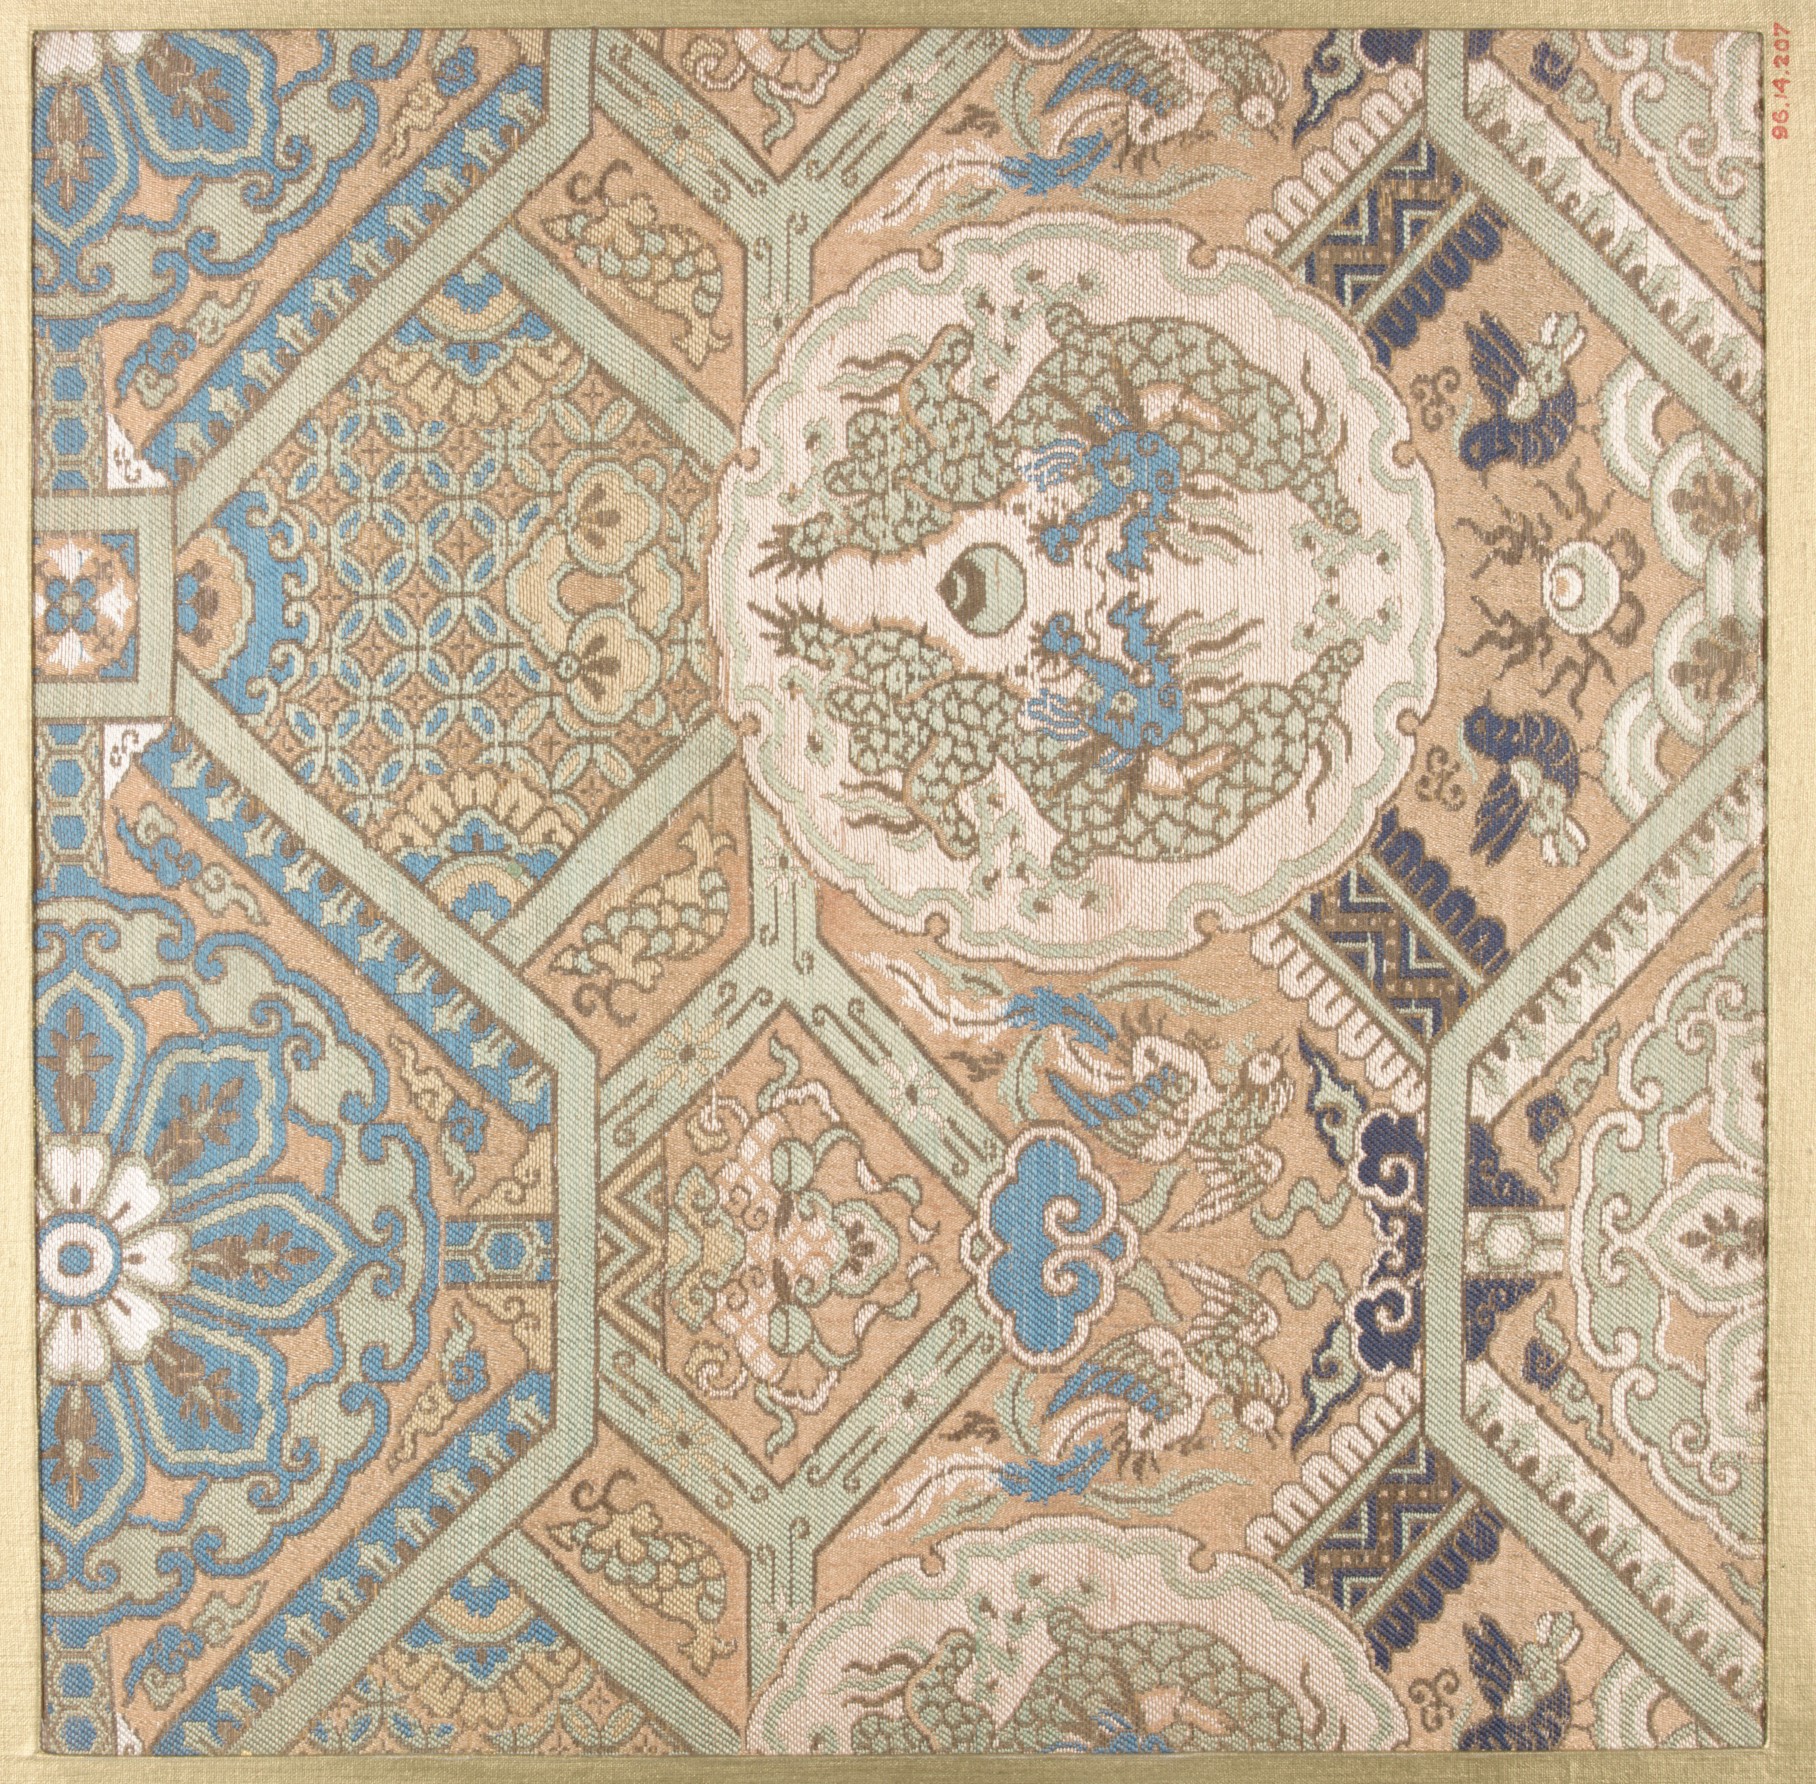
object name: piece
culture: japanese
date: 1701-1900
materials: silk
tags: birds,dragons